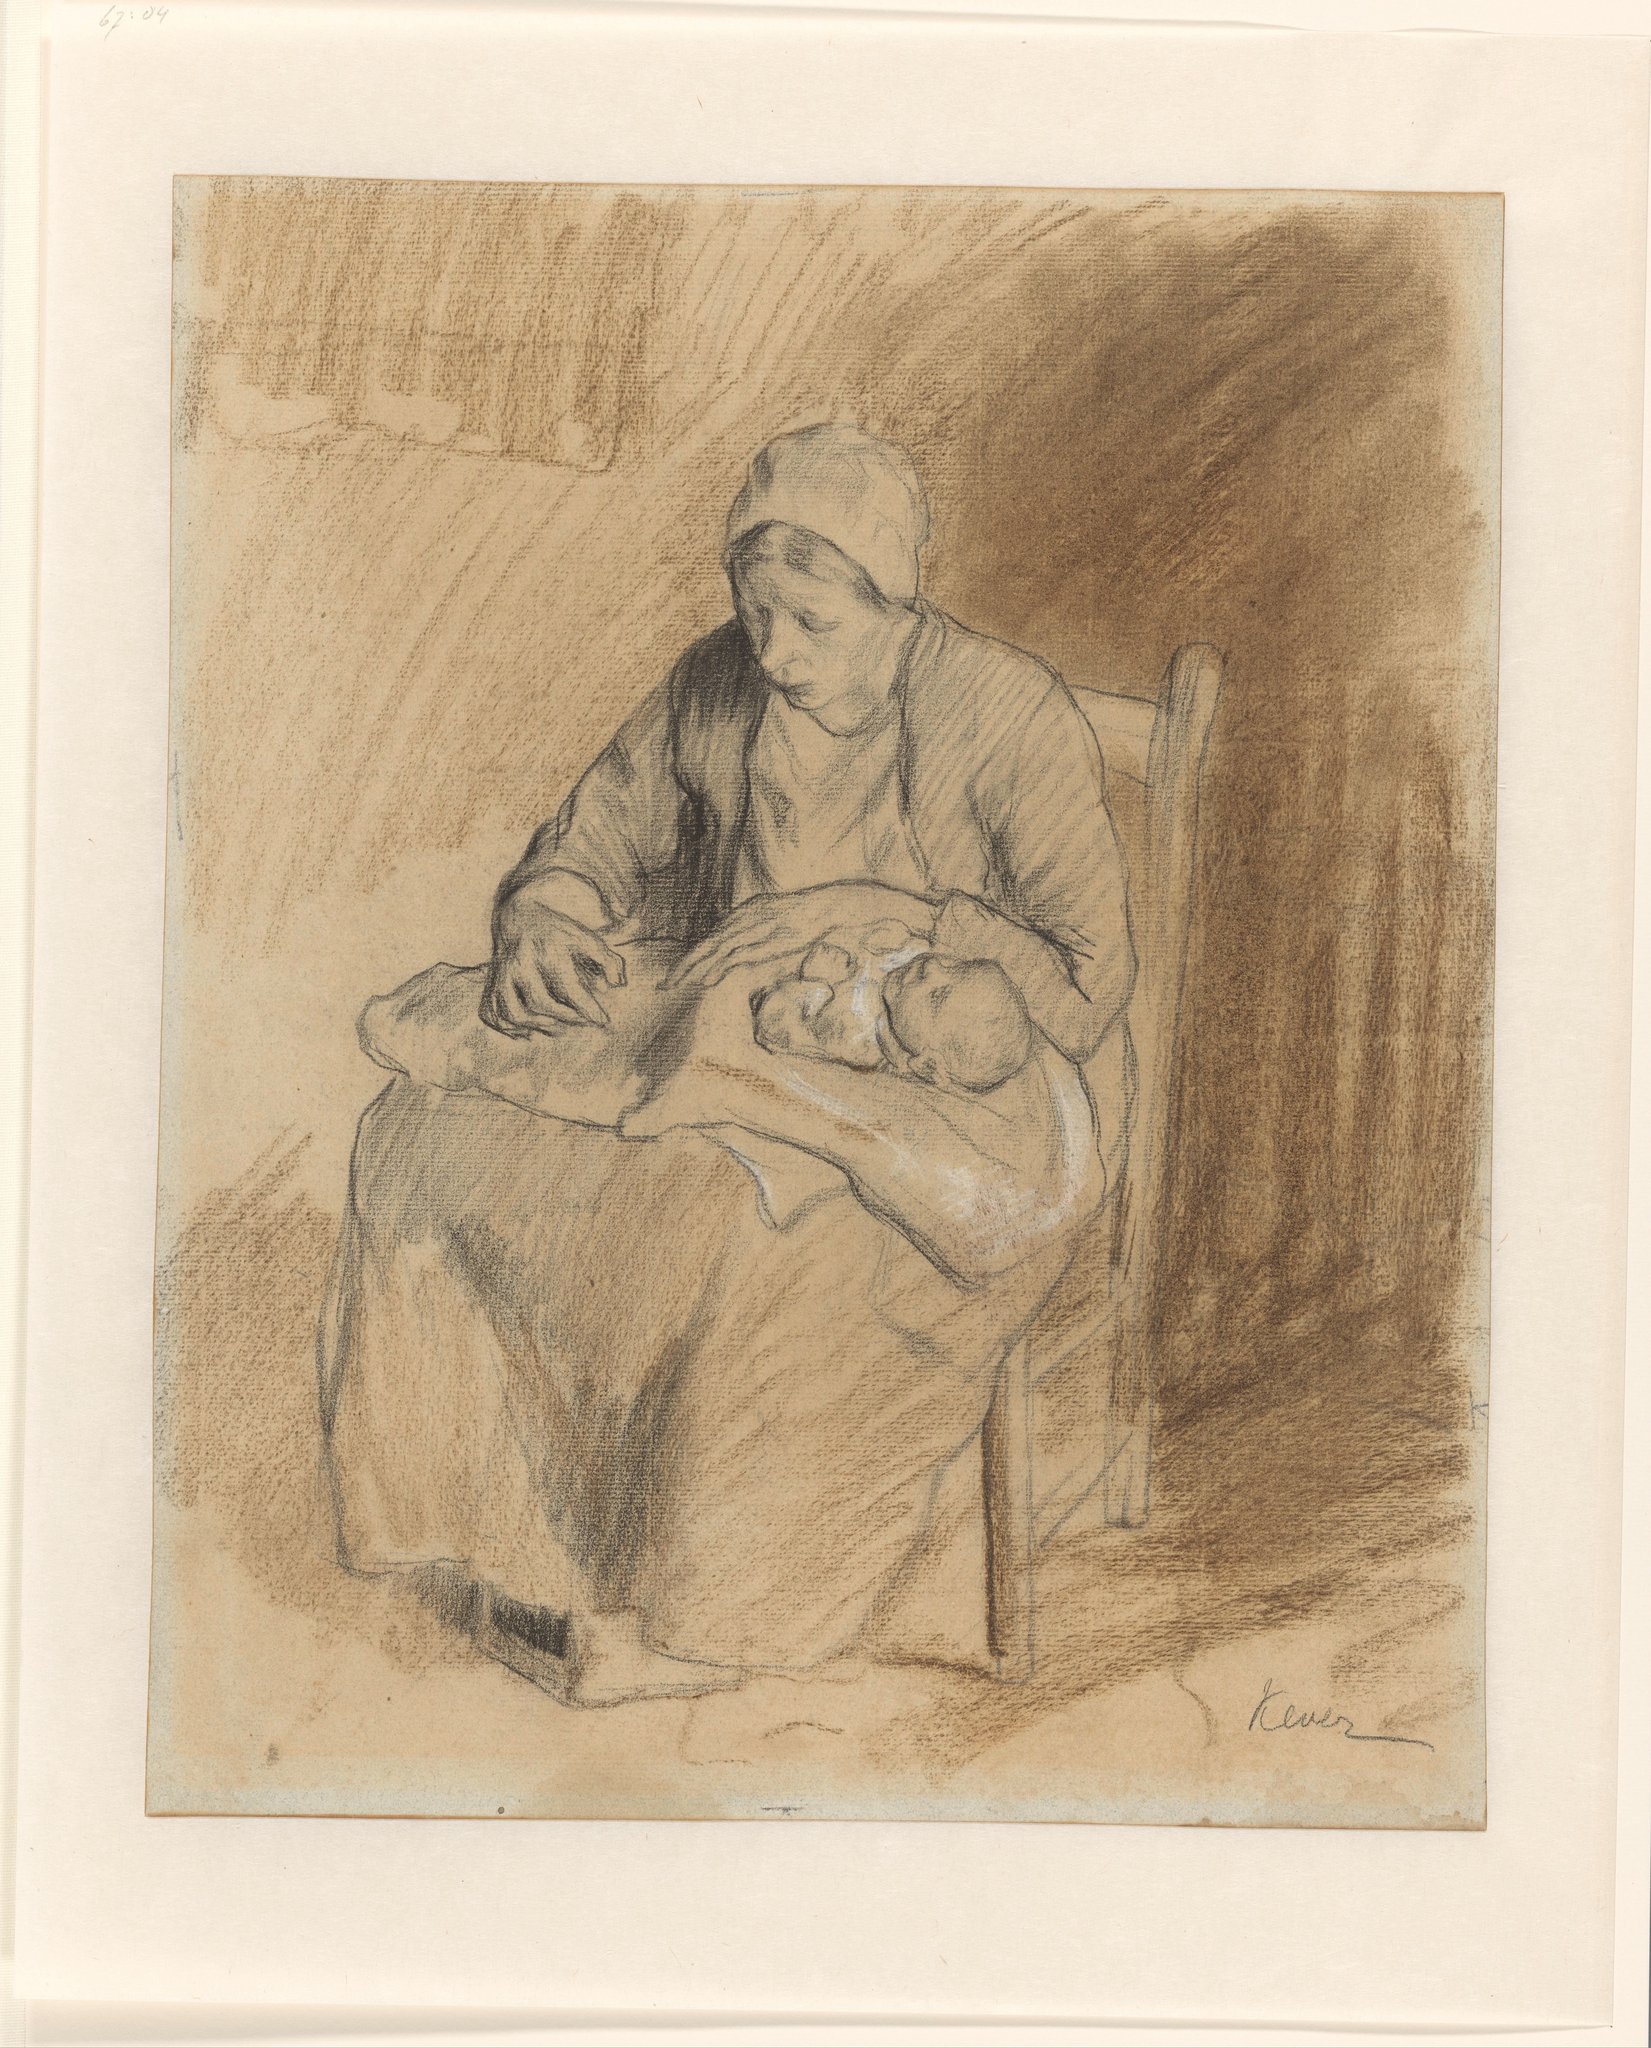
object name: drawing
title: Zittende vrouw met kind op schoot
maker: jacob simon hendrik kever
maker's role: draughtsman, painter, print maker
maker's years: 1854-1922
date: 1864-1922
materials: chalk, paper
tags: mother and baby or young child